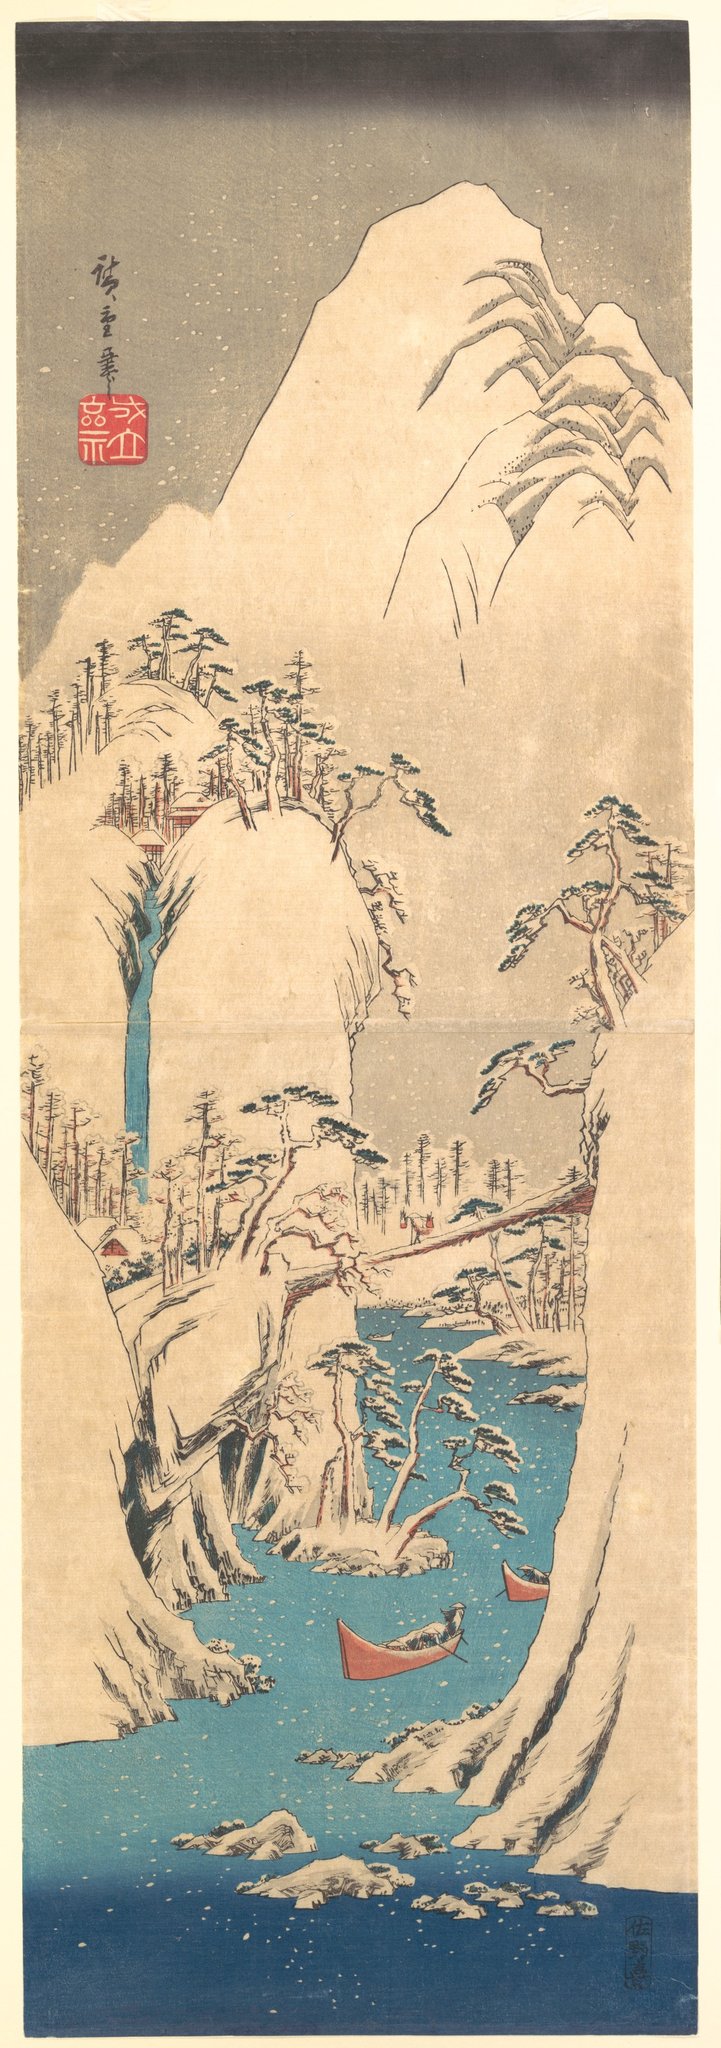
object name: print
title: Snowy Gorge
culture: japanese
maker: utagawa hiroshige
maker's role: artist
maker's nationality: japanese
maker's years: 1797-1858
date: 1615-1868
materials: ink, paper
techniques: woodblock print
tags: rivers,mountains,snow,boats